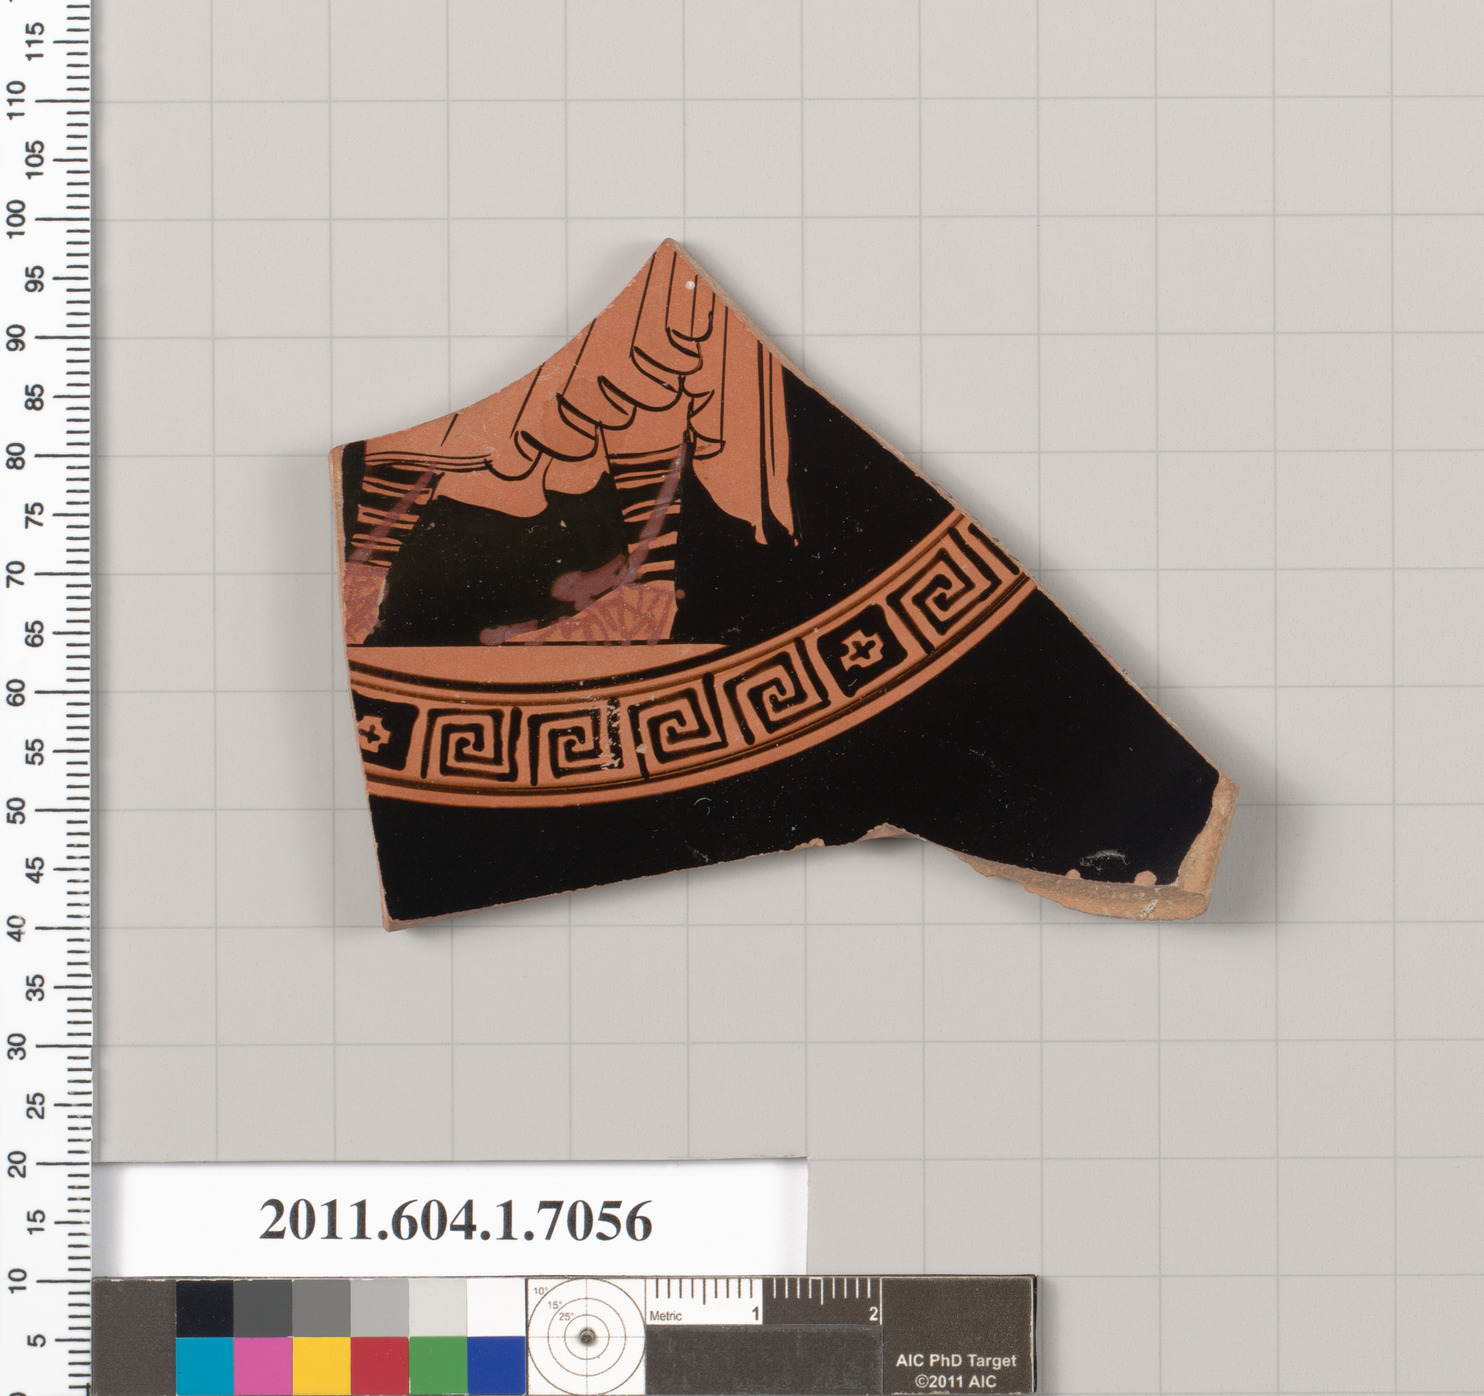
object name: kylix fragment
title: Terracotta fragment of a kylix (drinking cup)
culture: greek, attic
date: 500-480 BCE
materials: terracotta